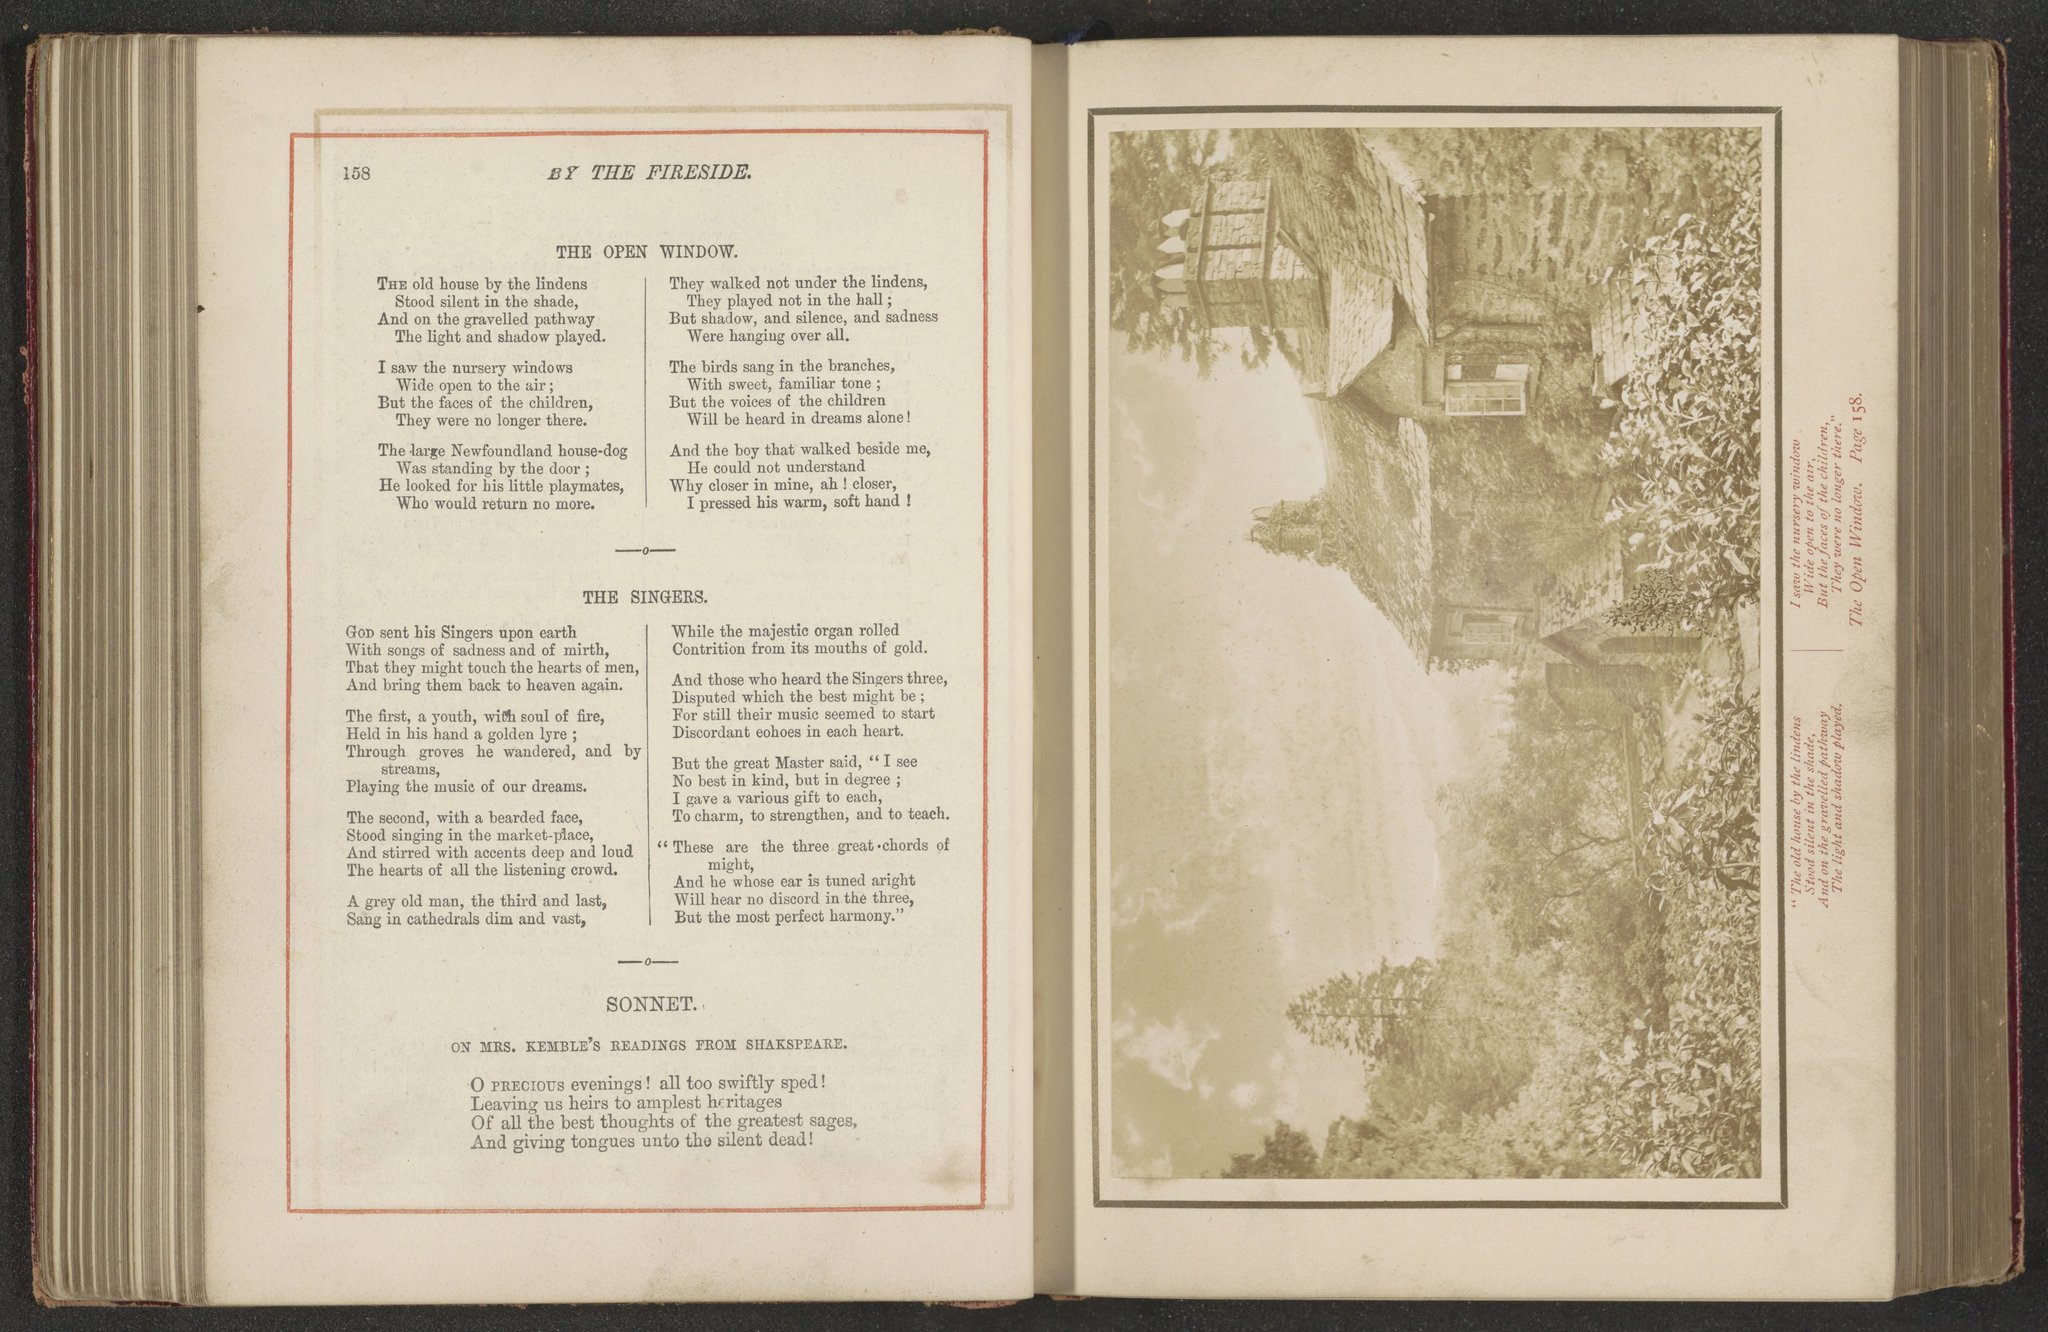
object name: photograph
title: Gezicht op een huis met een open raam in de bossen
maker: john payne jennings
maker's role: fotograaf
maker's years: 1843-1926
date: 1867-1877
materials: photographic support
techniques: albumen print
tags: open window, country-house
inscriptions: inscription: ‘"The old house by the lindens stood silent in the shade (...) Page 158.’